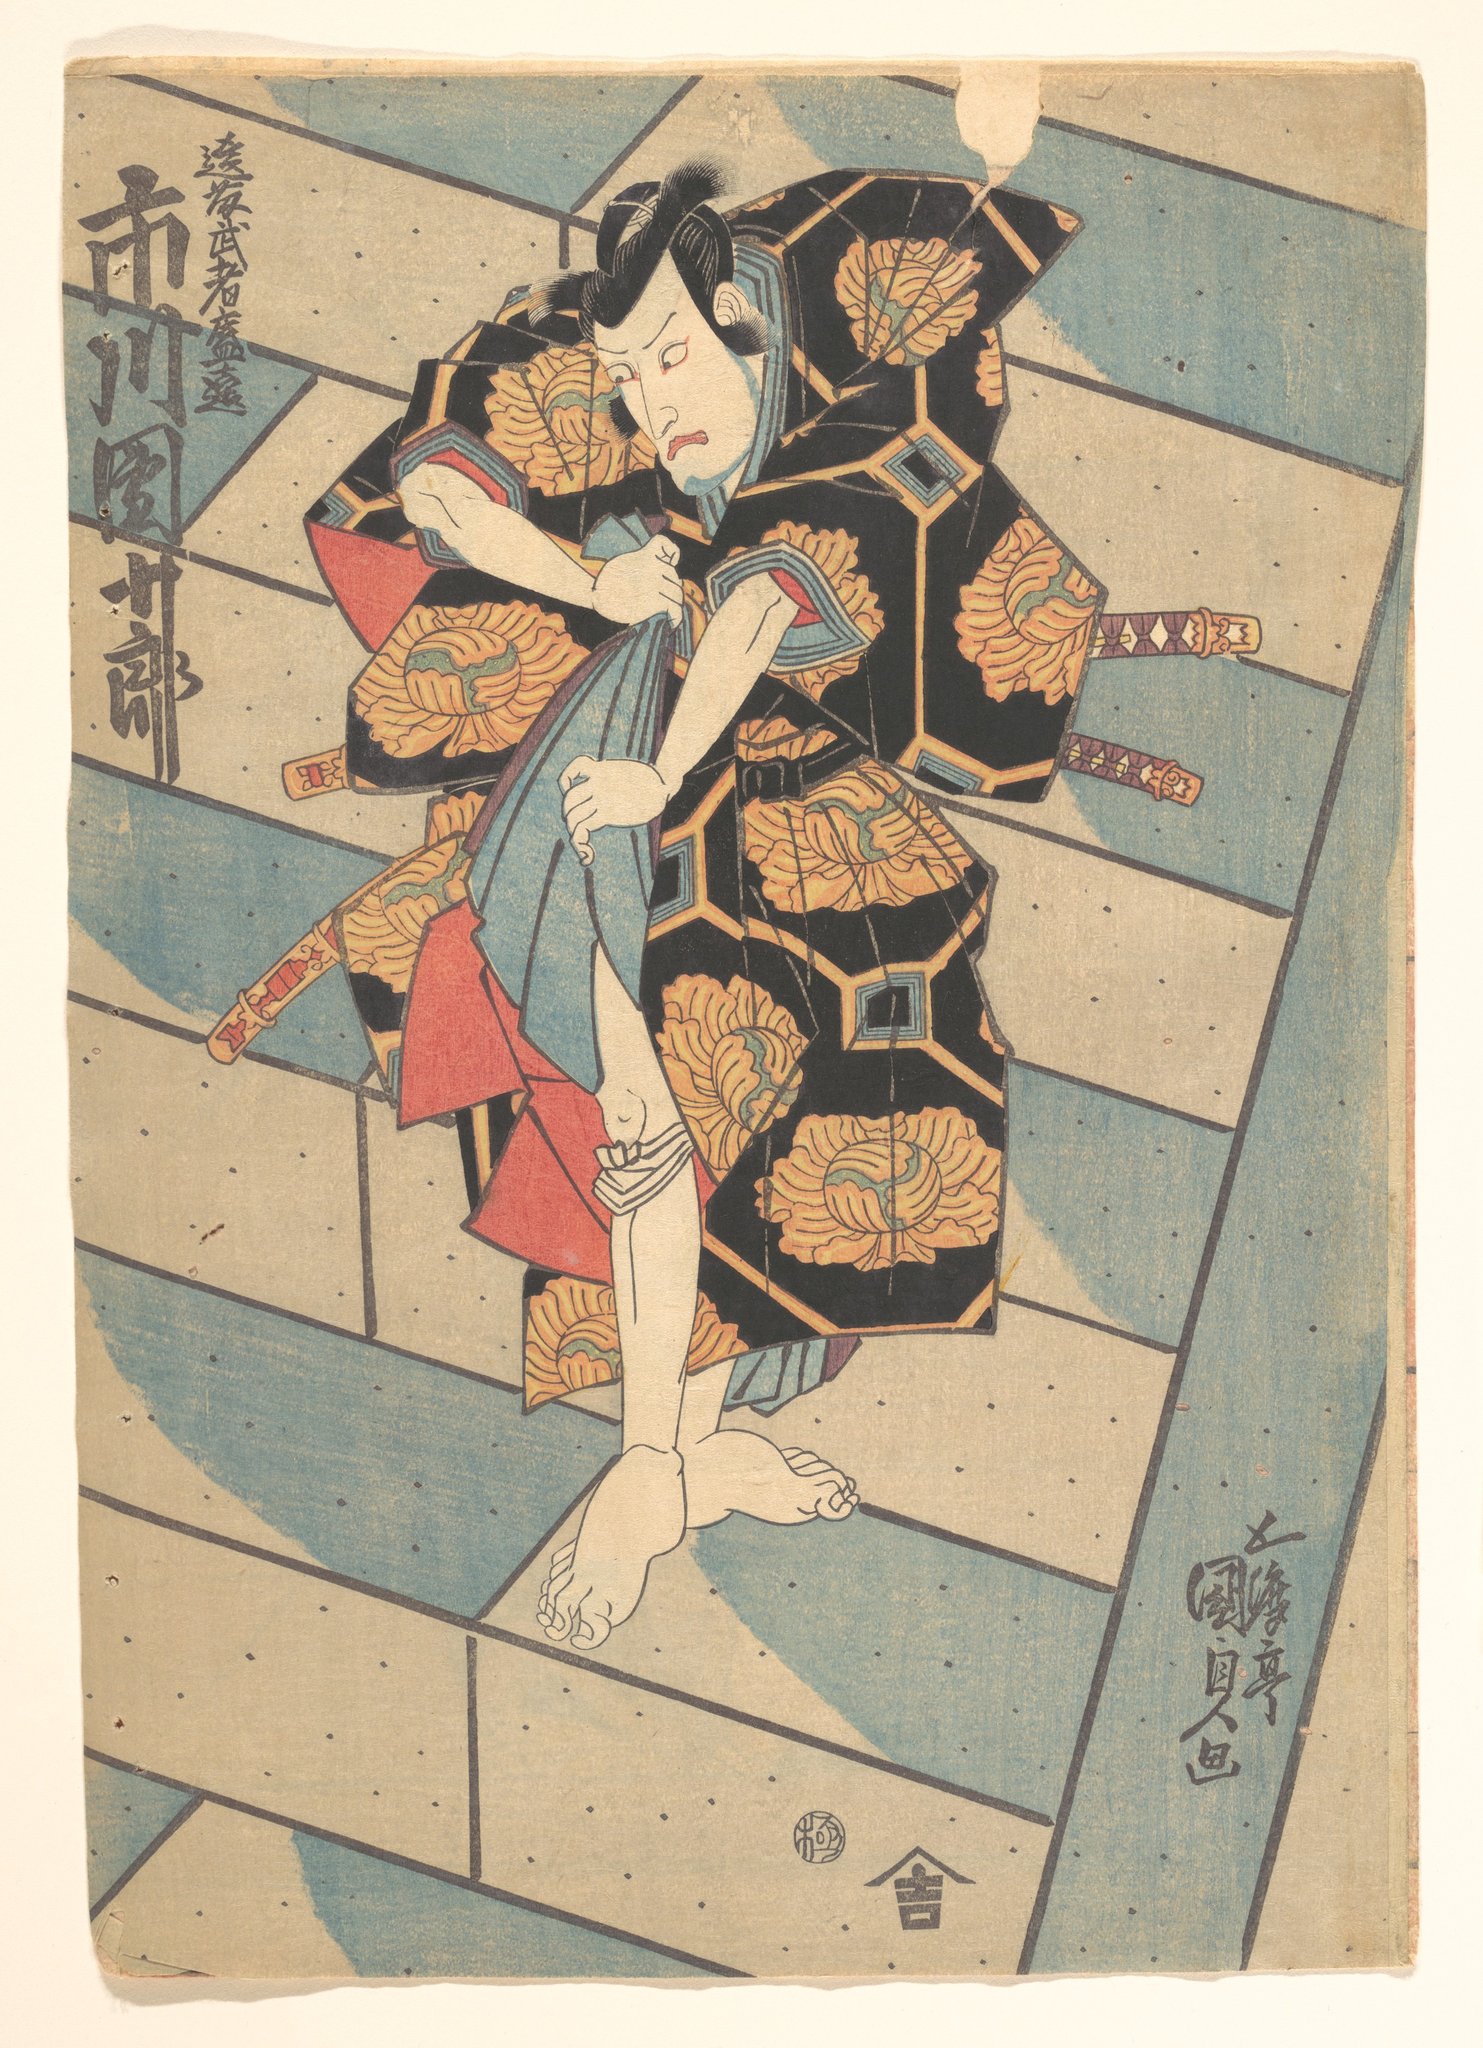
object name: print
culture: japanese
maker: utagawa kunisada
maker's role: artist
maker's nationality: japanese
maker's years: 1786-1864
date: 1801-1900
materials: ink, paper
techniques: woodblock print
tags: men